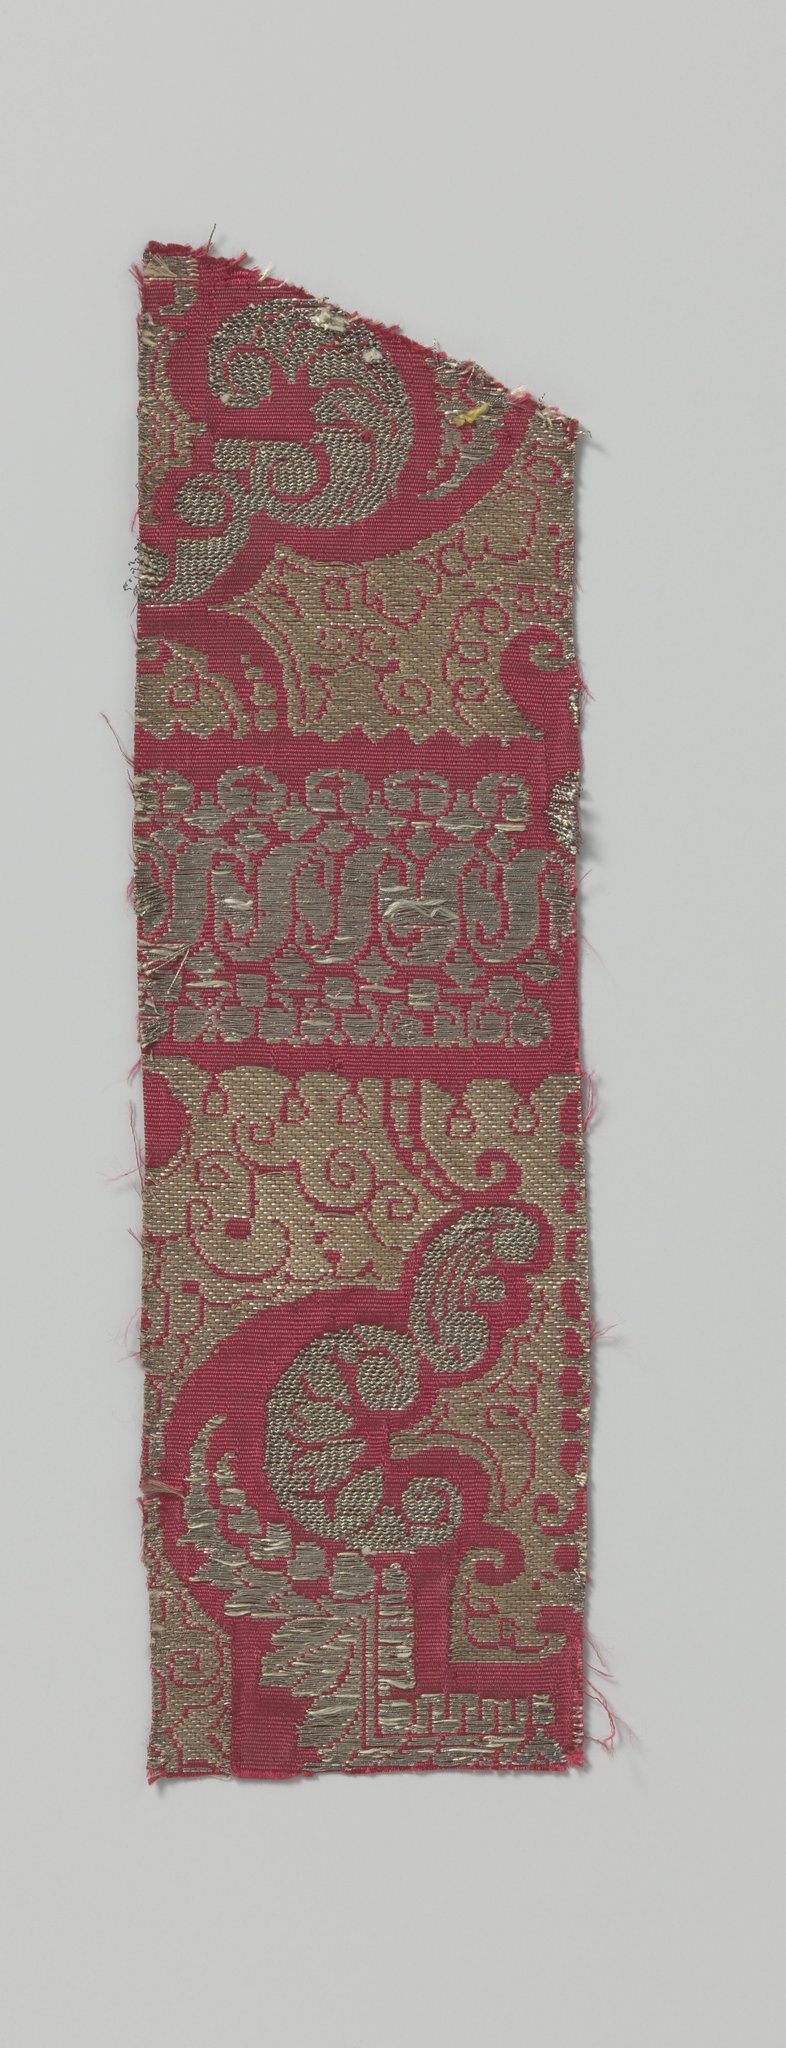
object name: fragment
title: Fragment van rode zijde met patroon in goud- en zilverdraad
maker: Anonymous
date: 1600-1699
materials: silk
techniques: lampas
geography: netherlands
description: Fragment van rode zijde met een patroon in keper van gebrocheerd goud- en zilverdraad, waarschijnlijk in de vorm van cartouches, gevuld met vederpluim-vormige figuren, en omgegeven door brede ornamentbanden.